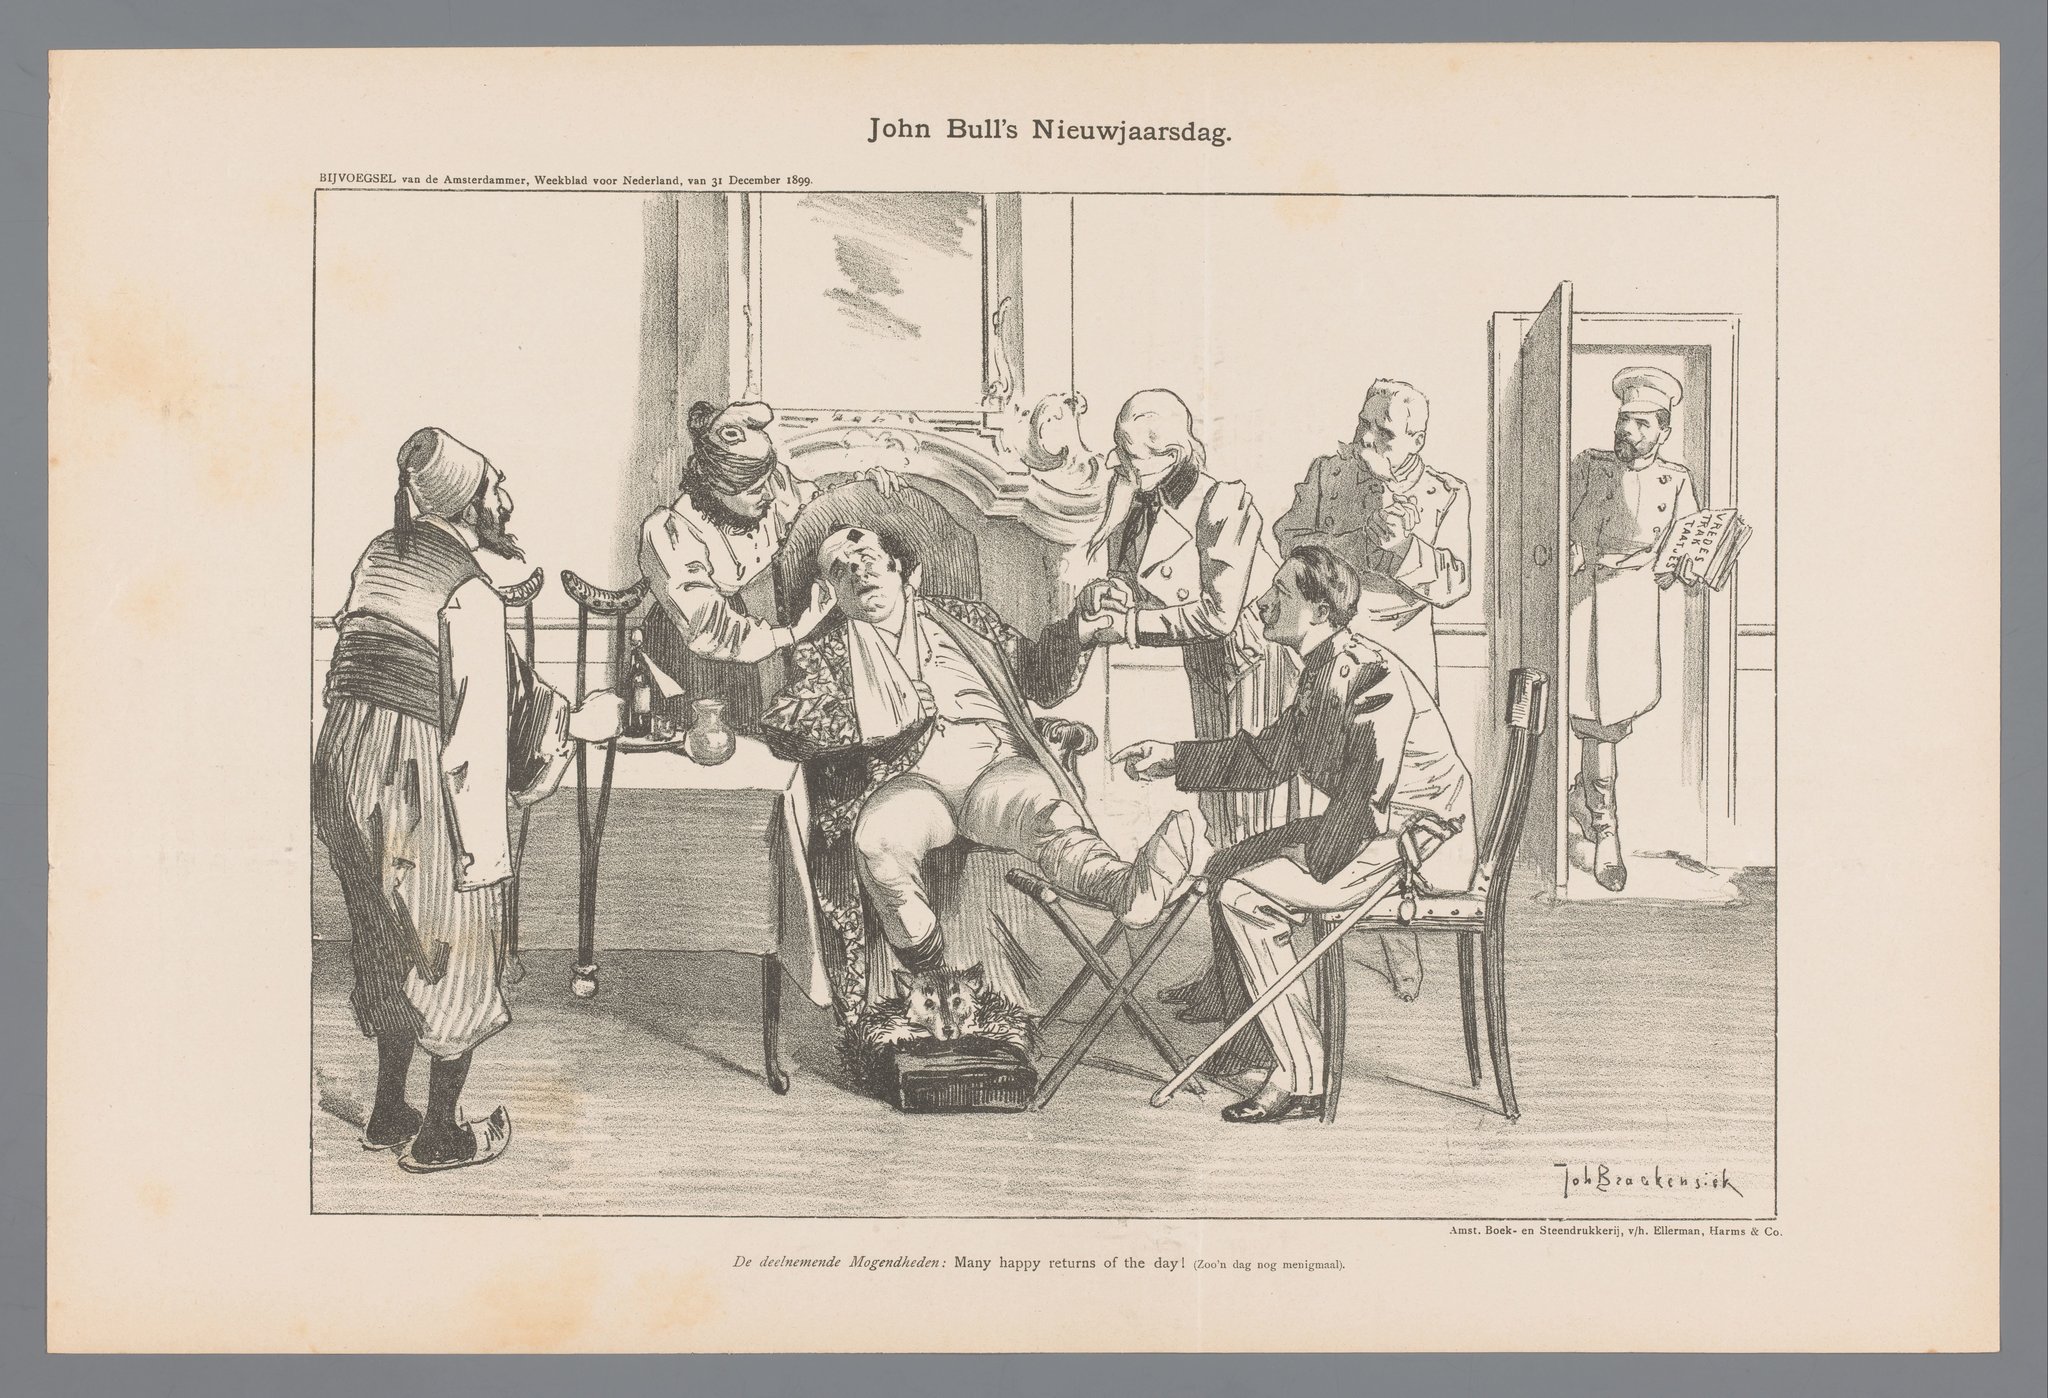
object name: cartoon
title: John Bull's Nieuwjaarsdag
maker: johan braakensiek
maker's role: draughtsman, print maker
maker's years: 1858-1940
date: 1899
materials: paper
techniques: lithograph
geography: amsterdam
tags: personifications of countries, nations, states, districts, etc., january 1 (~ festivities), ruler, sovereign, political caricatures and satires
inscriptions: date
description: Prent uit het bijvoegsel van: De Amsterdammer. Weekblad voor Nederland, 31 december 1899.